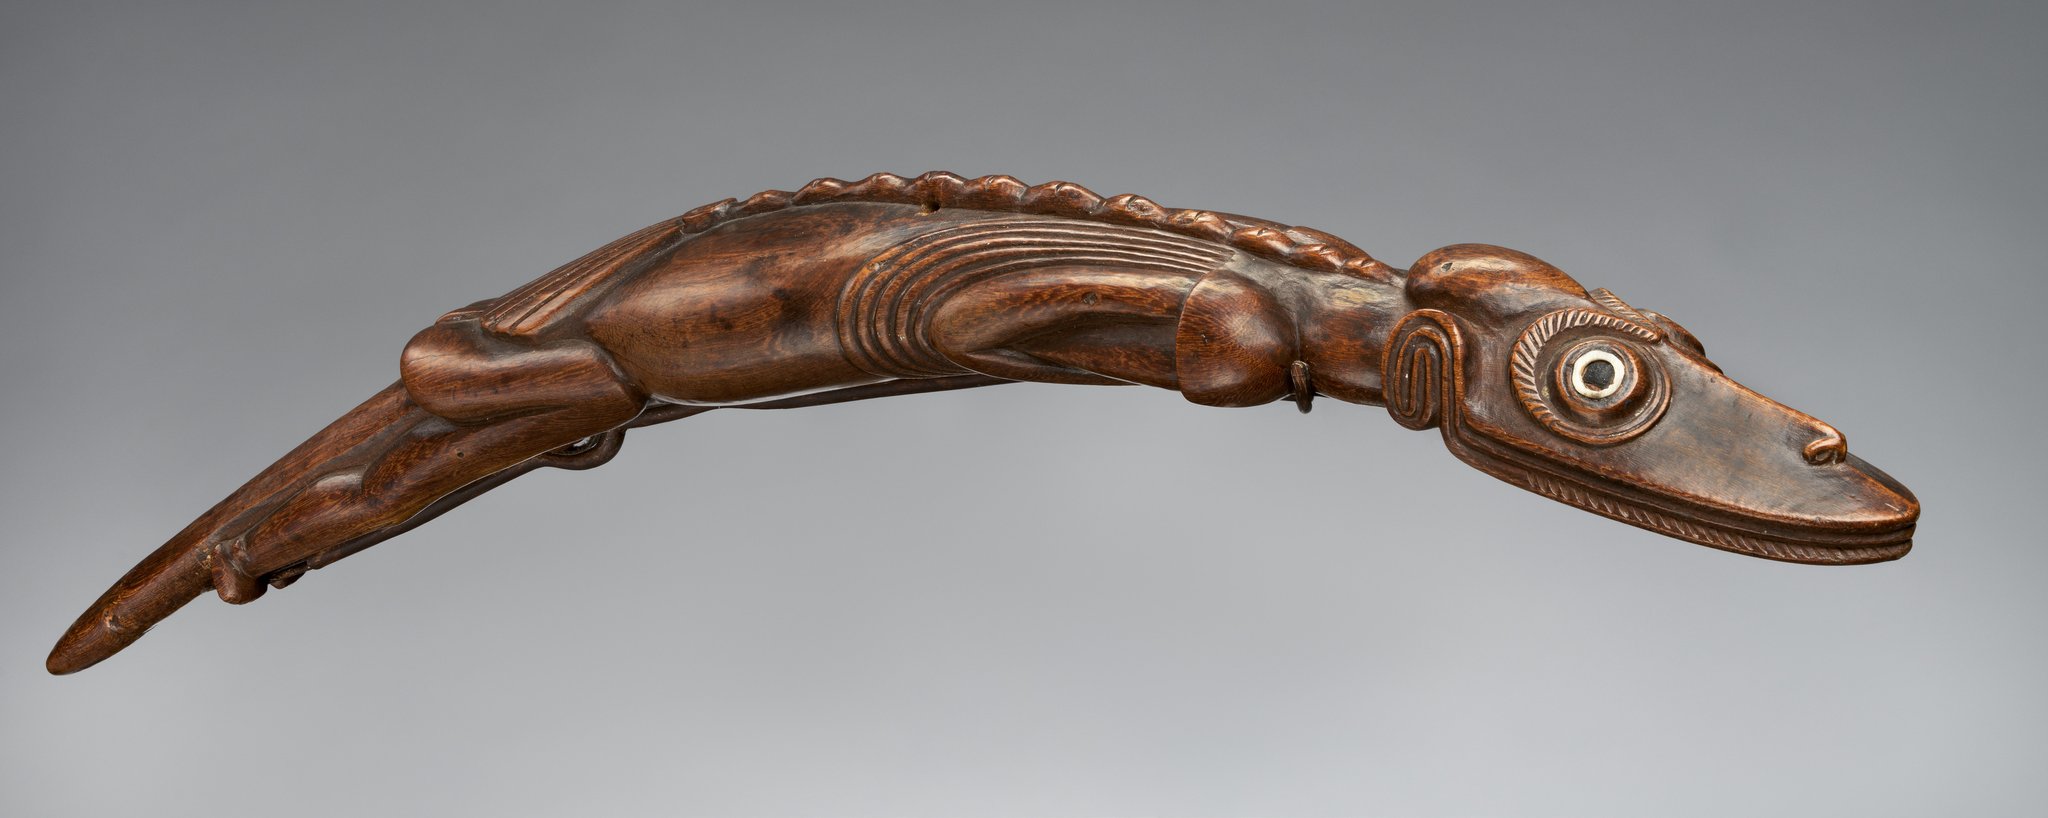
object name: figure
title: "Lizardman" Figure (Moko)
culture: rapa nui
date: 1801-1900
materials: bone, obsidian, wood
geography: chile